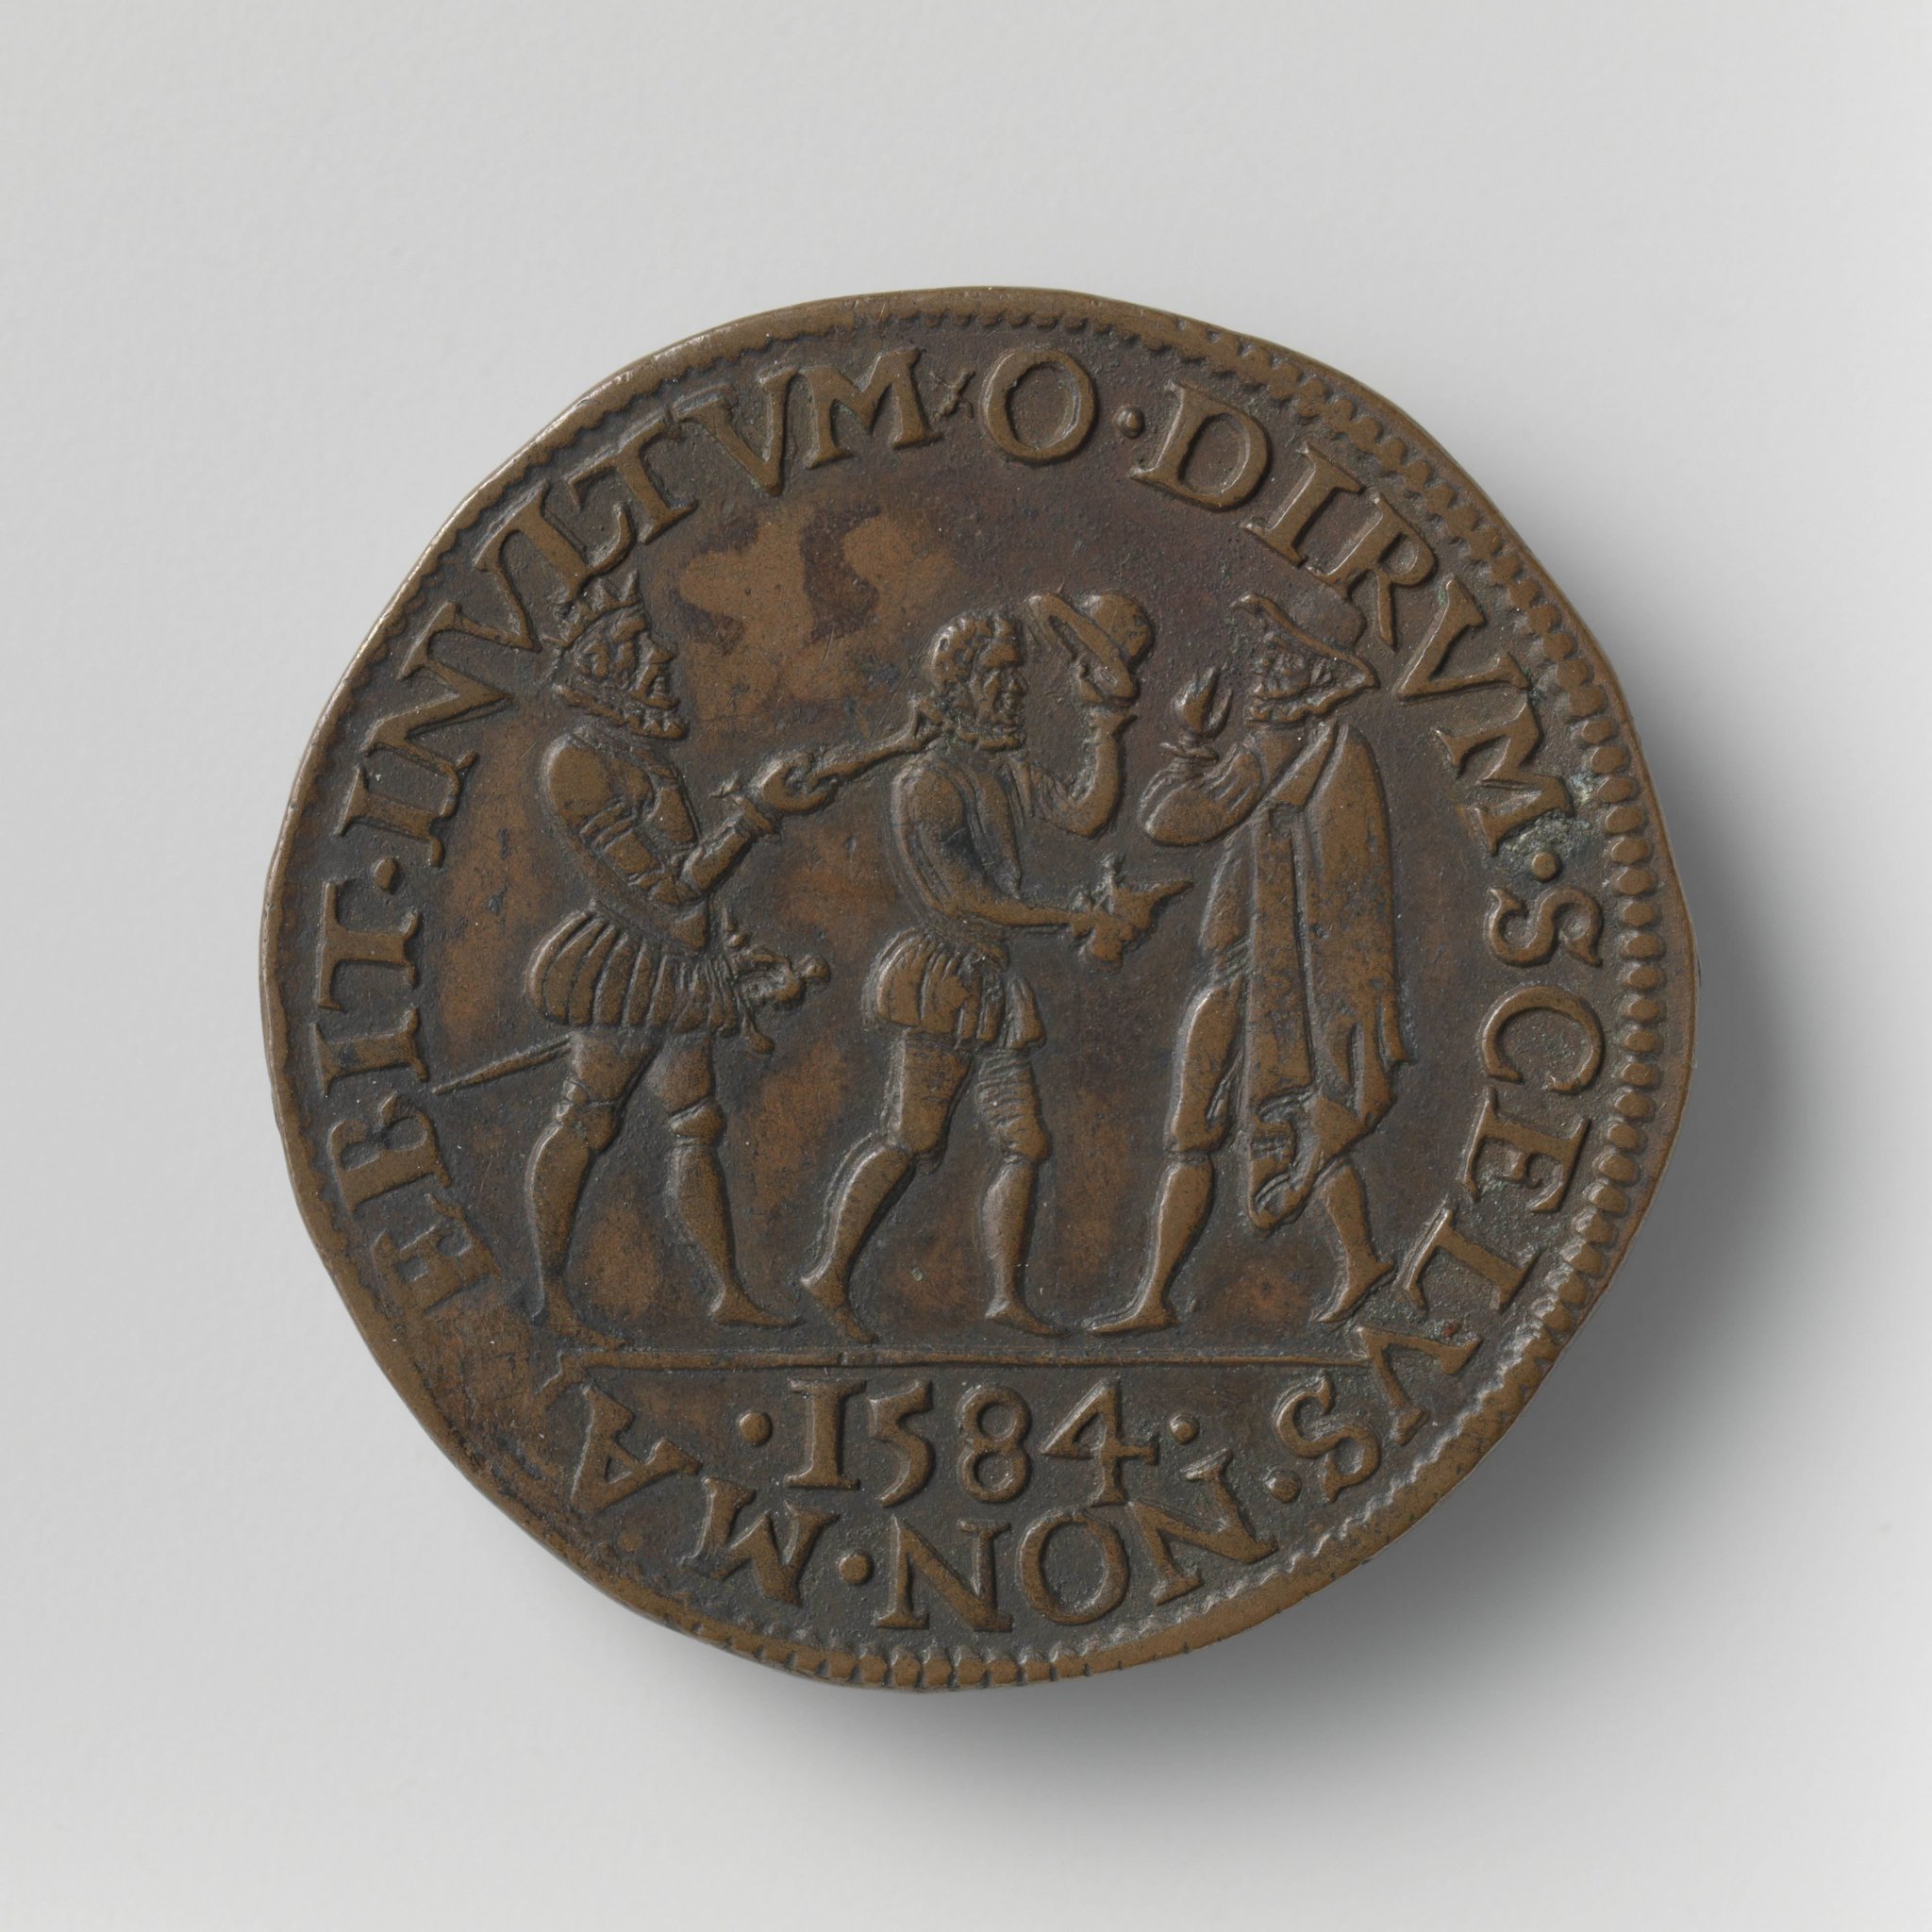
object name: jeton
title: Moord op Willem I, prins van Oranje-Nassau, door Balthasar Gerard te Delft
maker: gerard van bylaer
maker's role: die cutter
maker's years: 1540-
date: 1584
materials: copper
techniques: striking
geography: dordrecht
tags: philip ii of spain, delft, william i (prince of orange)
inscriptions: circumscription: ‘O DIRVM SCELVS NON MANEBIT INVLTVM / 1584’, circumscription: ‘PASTOREM OCCIDIT NE VOS CREDITE LVPO / CONFIDITE’